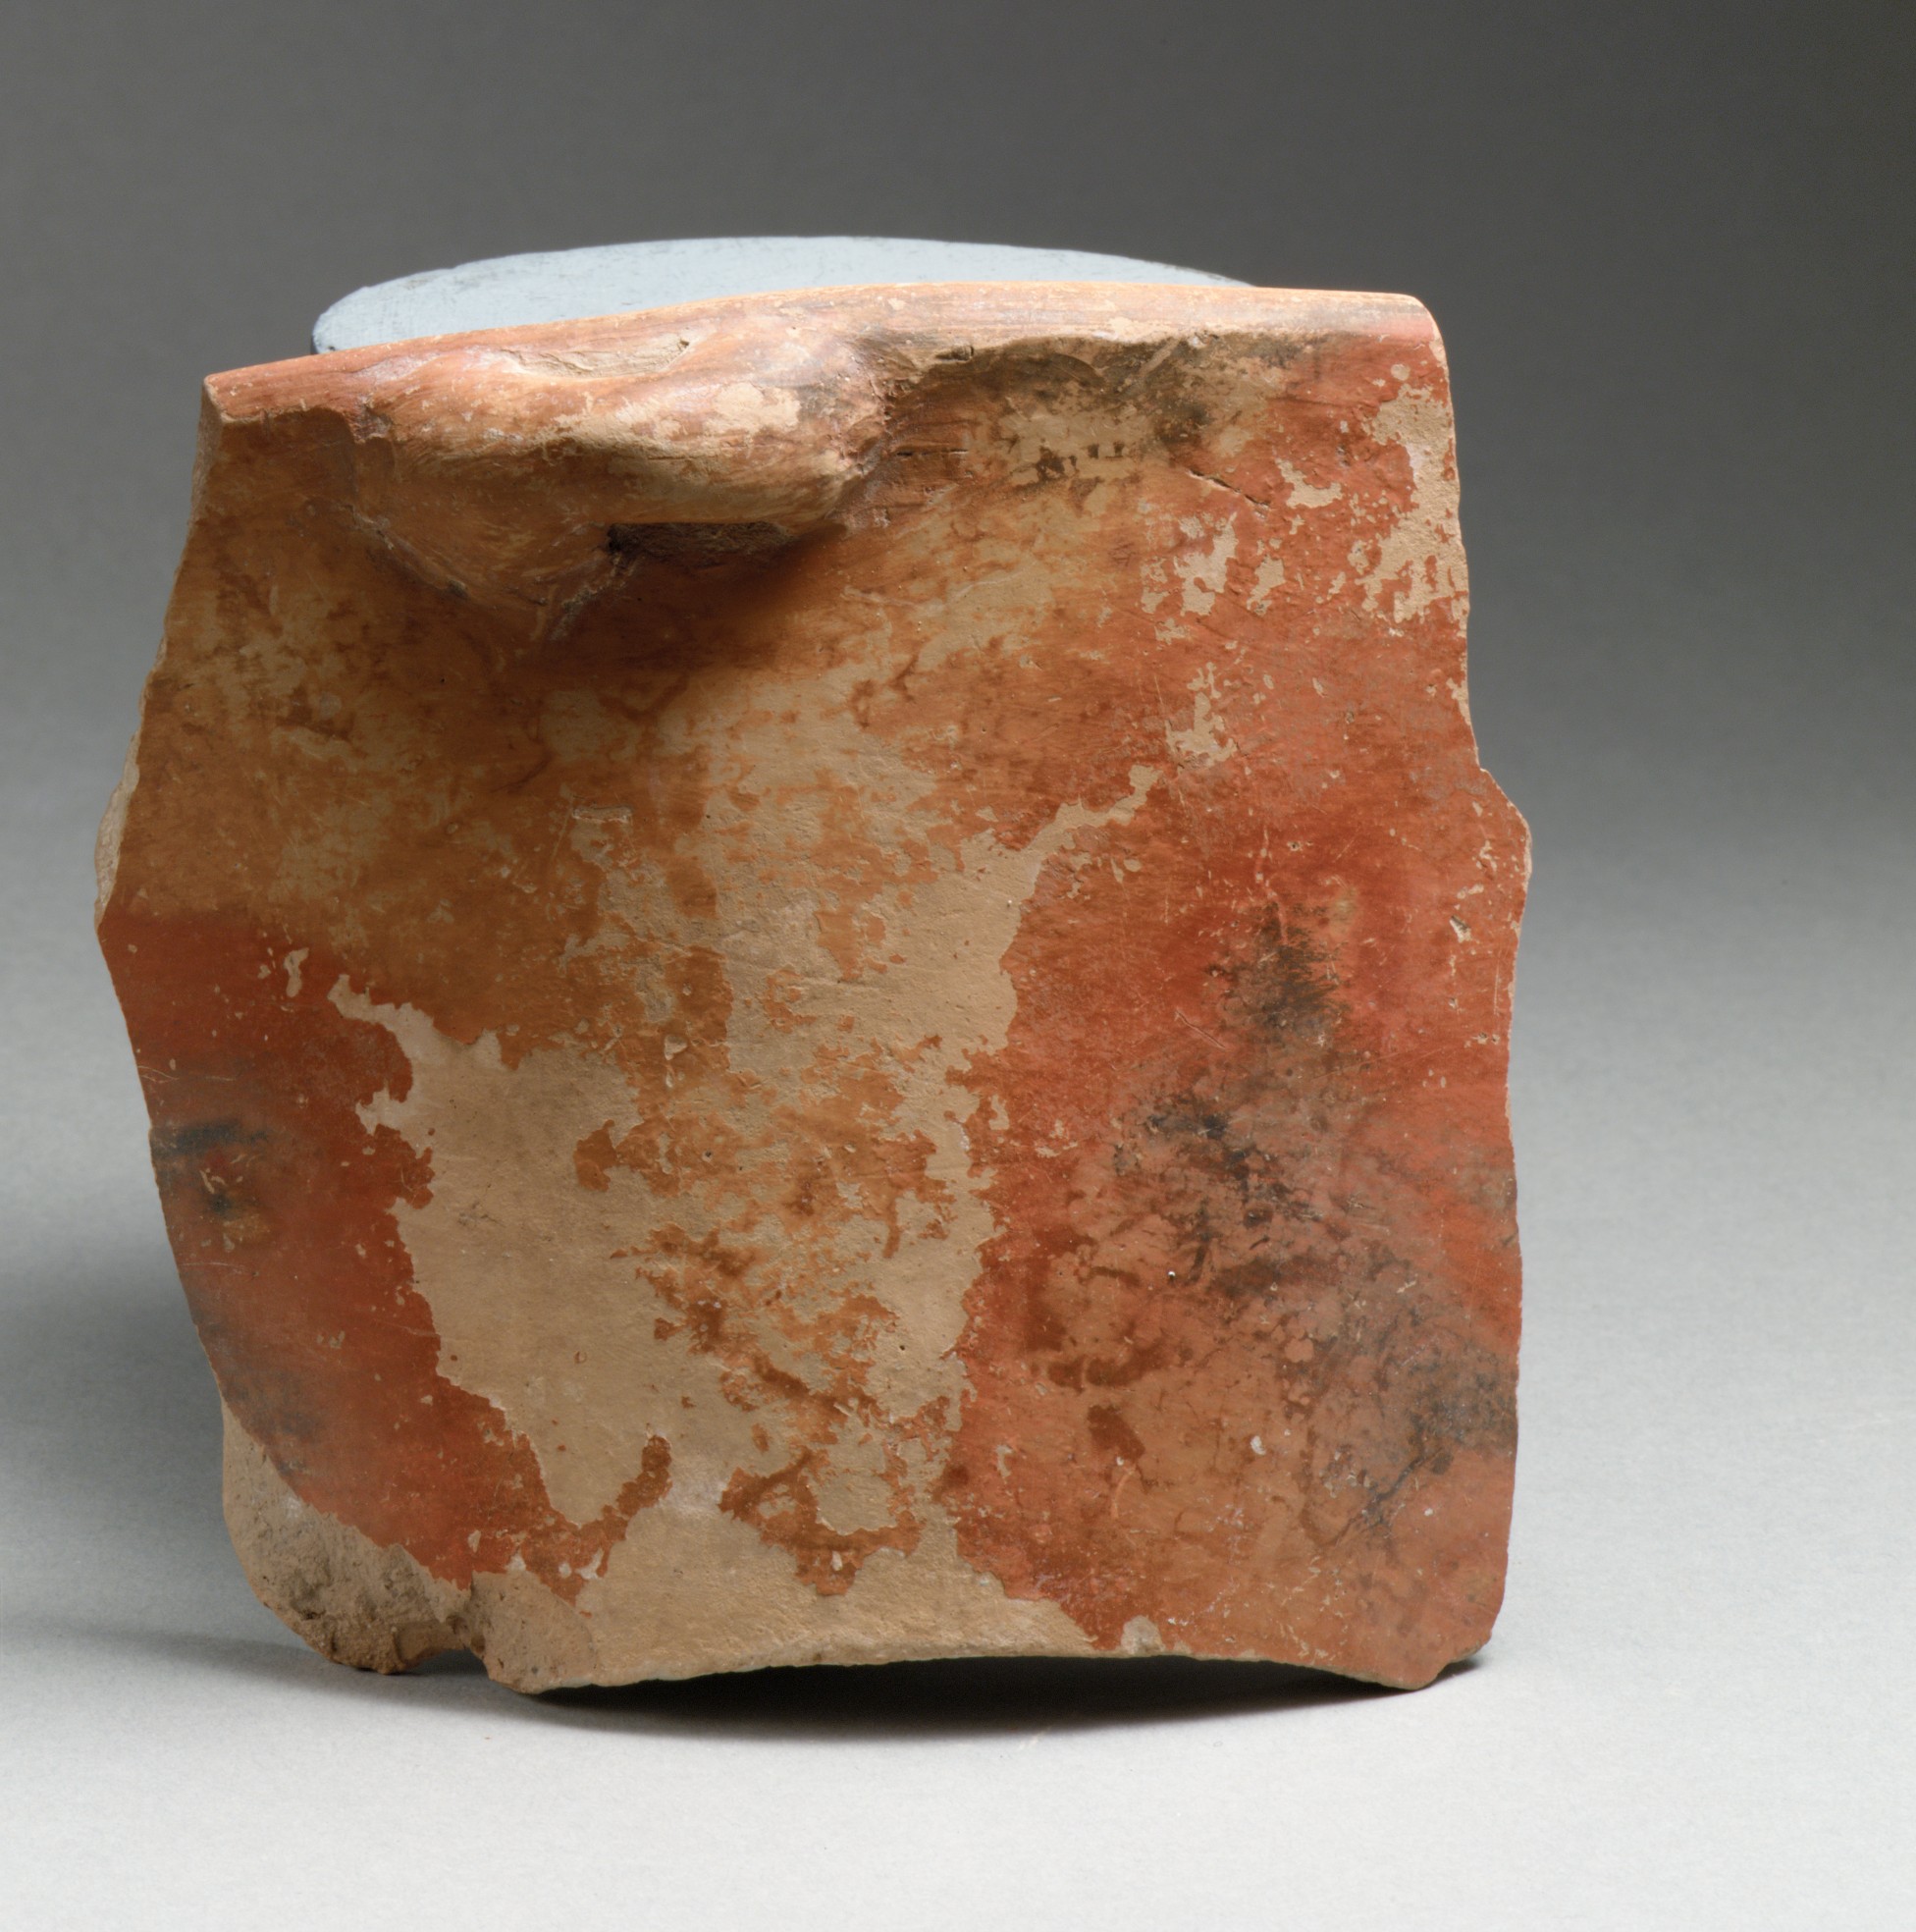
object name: vase fragment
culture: minoan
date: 2600-2000 BCE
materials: terracotta